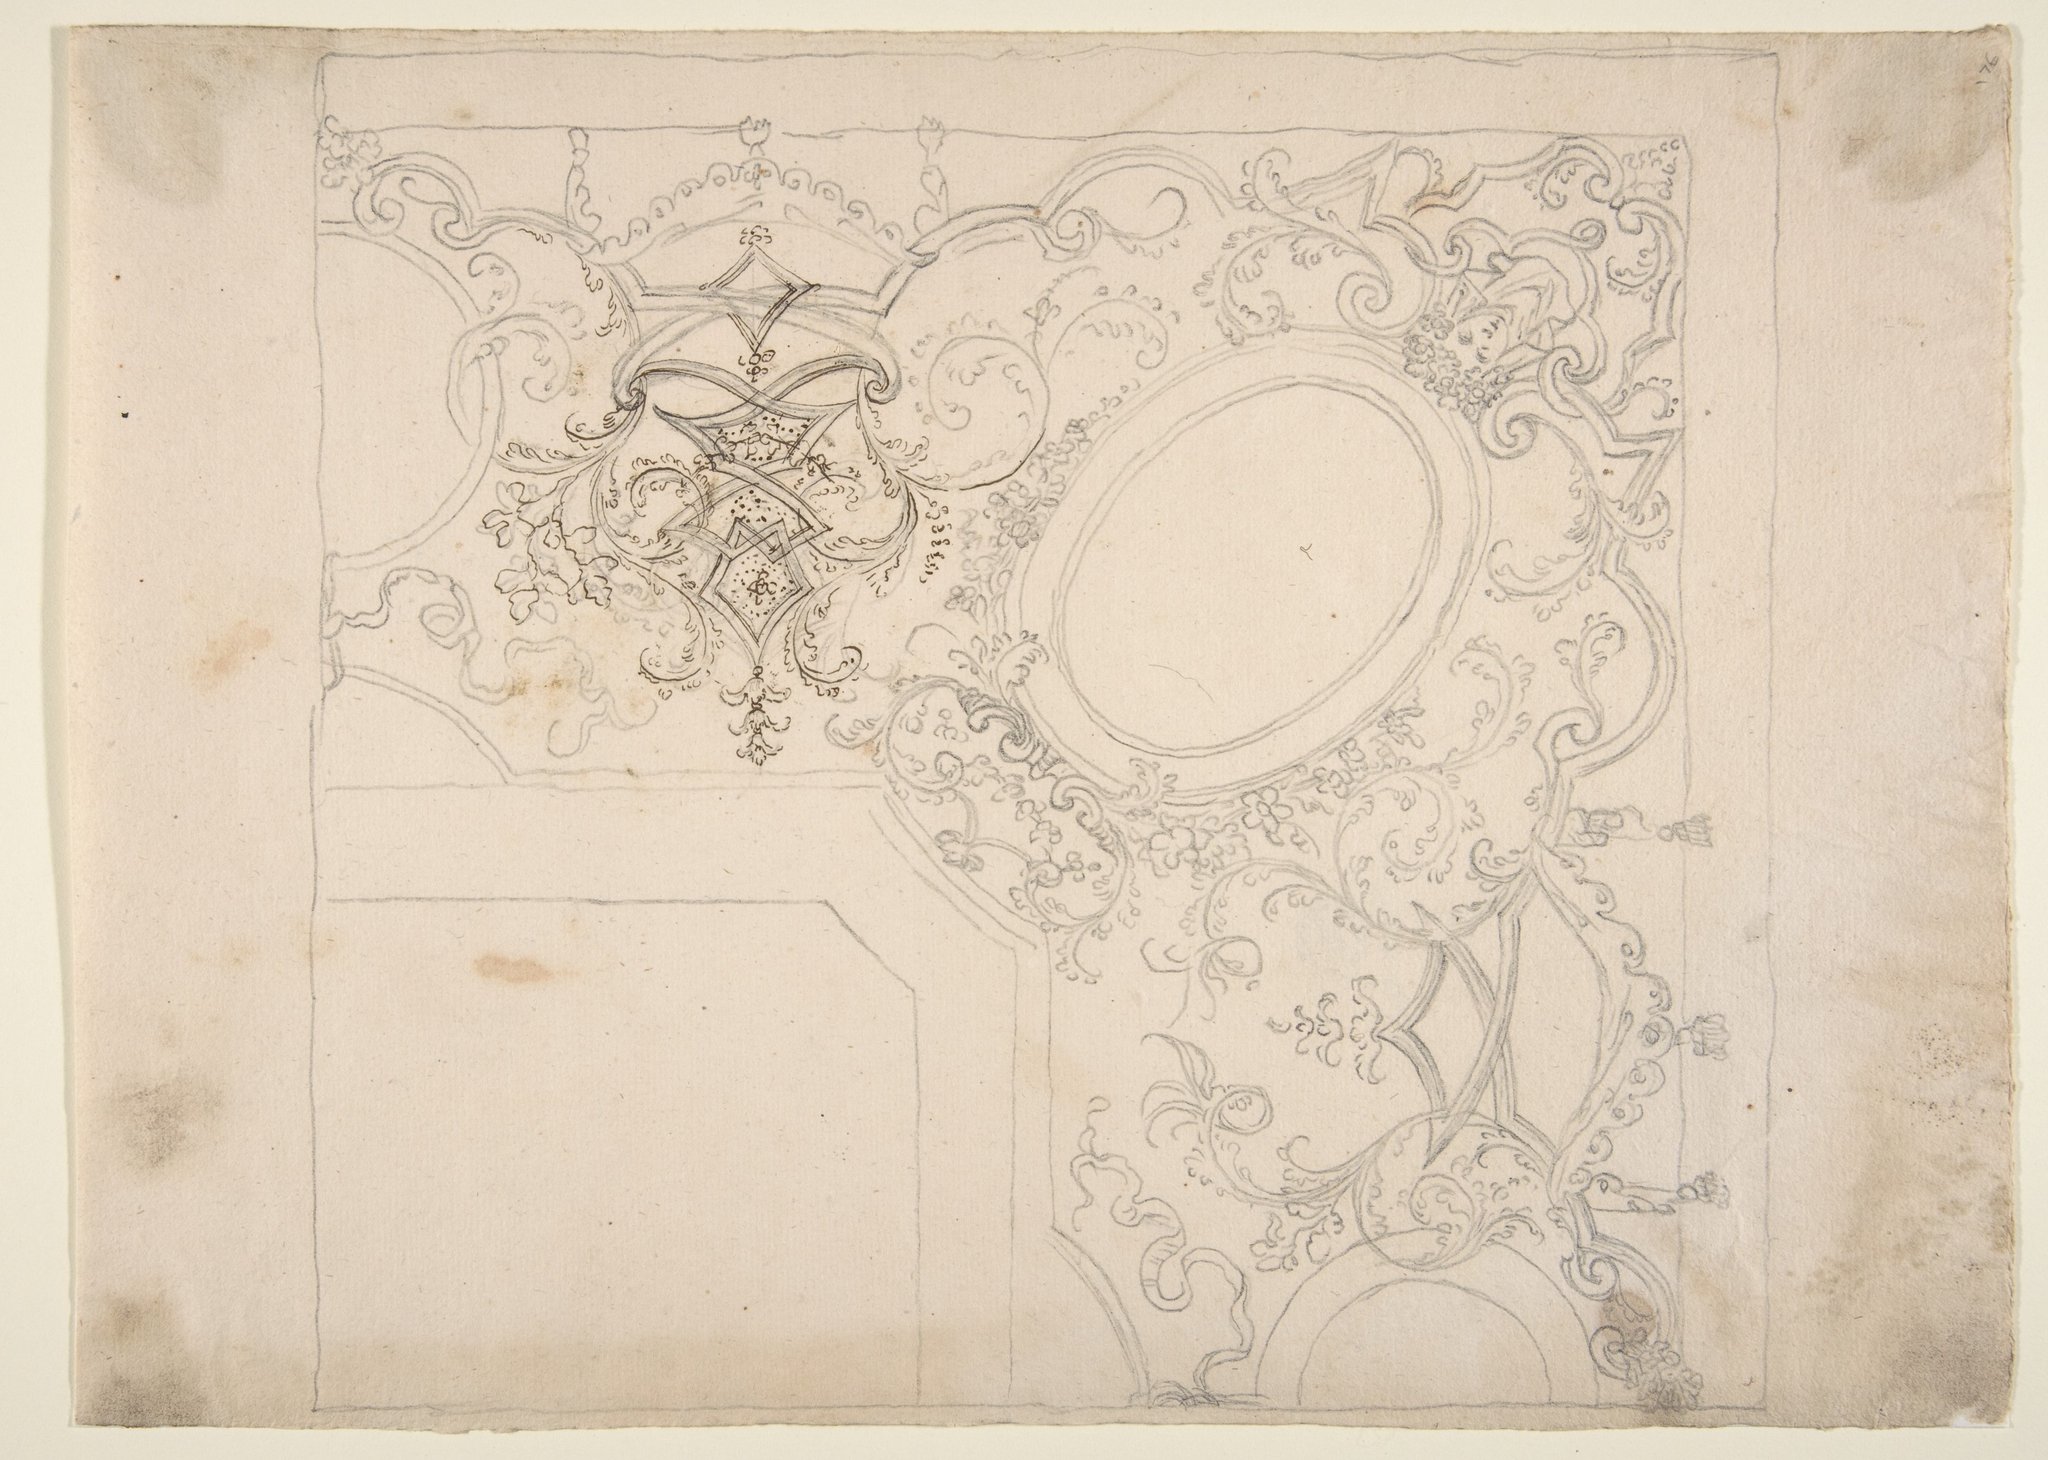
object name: drawing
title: Design for Ceiling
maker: leonardo marini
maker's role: artist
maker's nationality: italian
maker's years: 1730-1797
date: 1701-1800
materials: graphite, ink, drawing material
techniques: pen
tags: ceilings